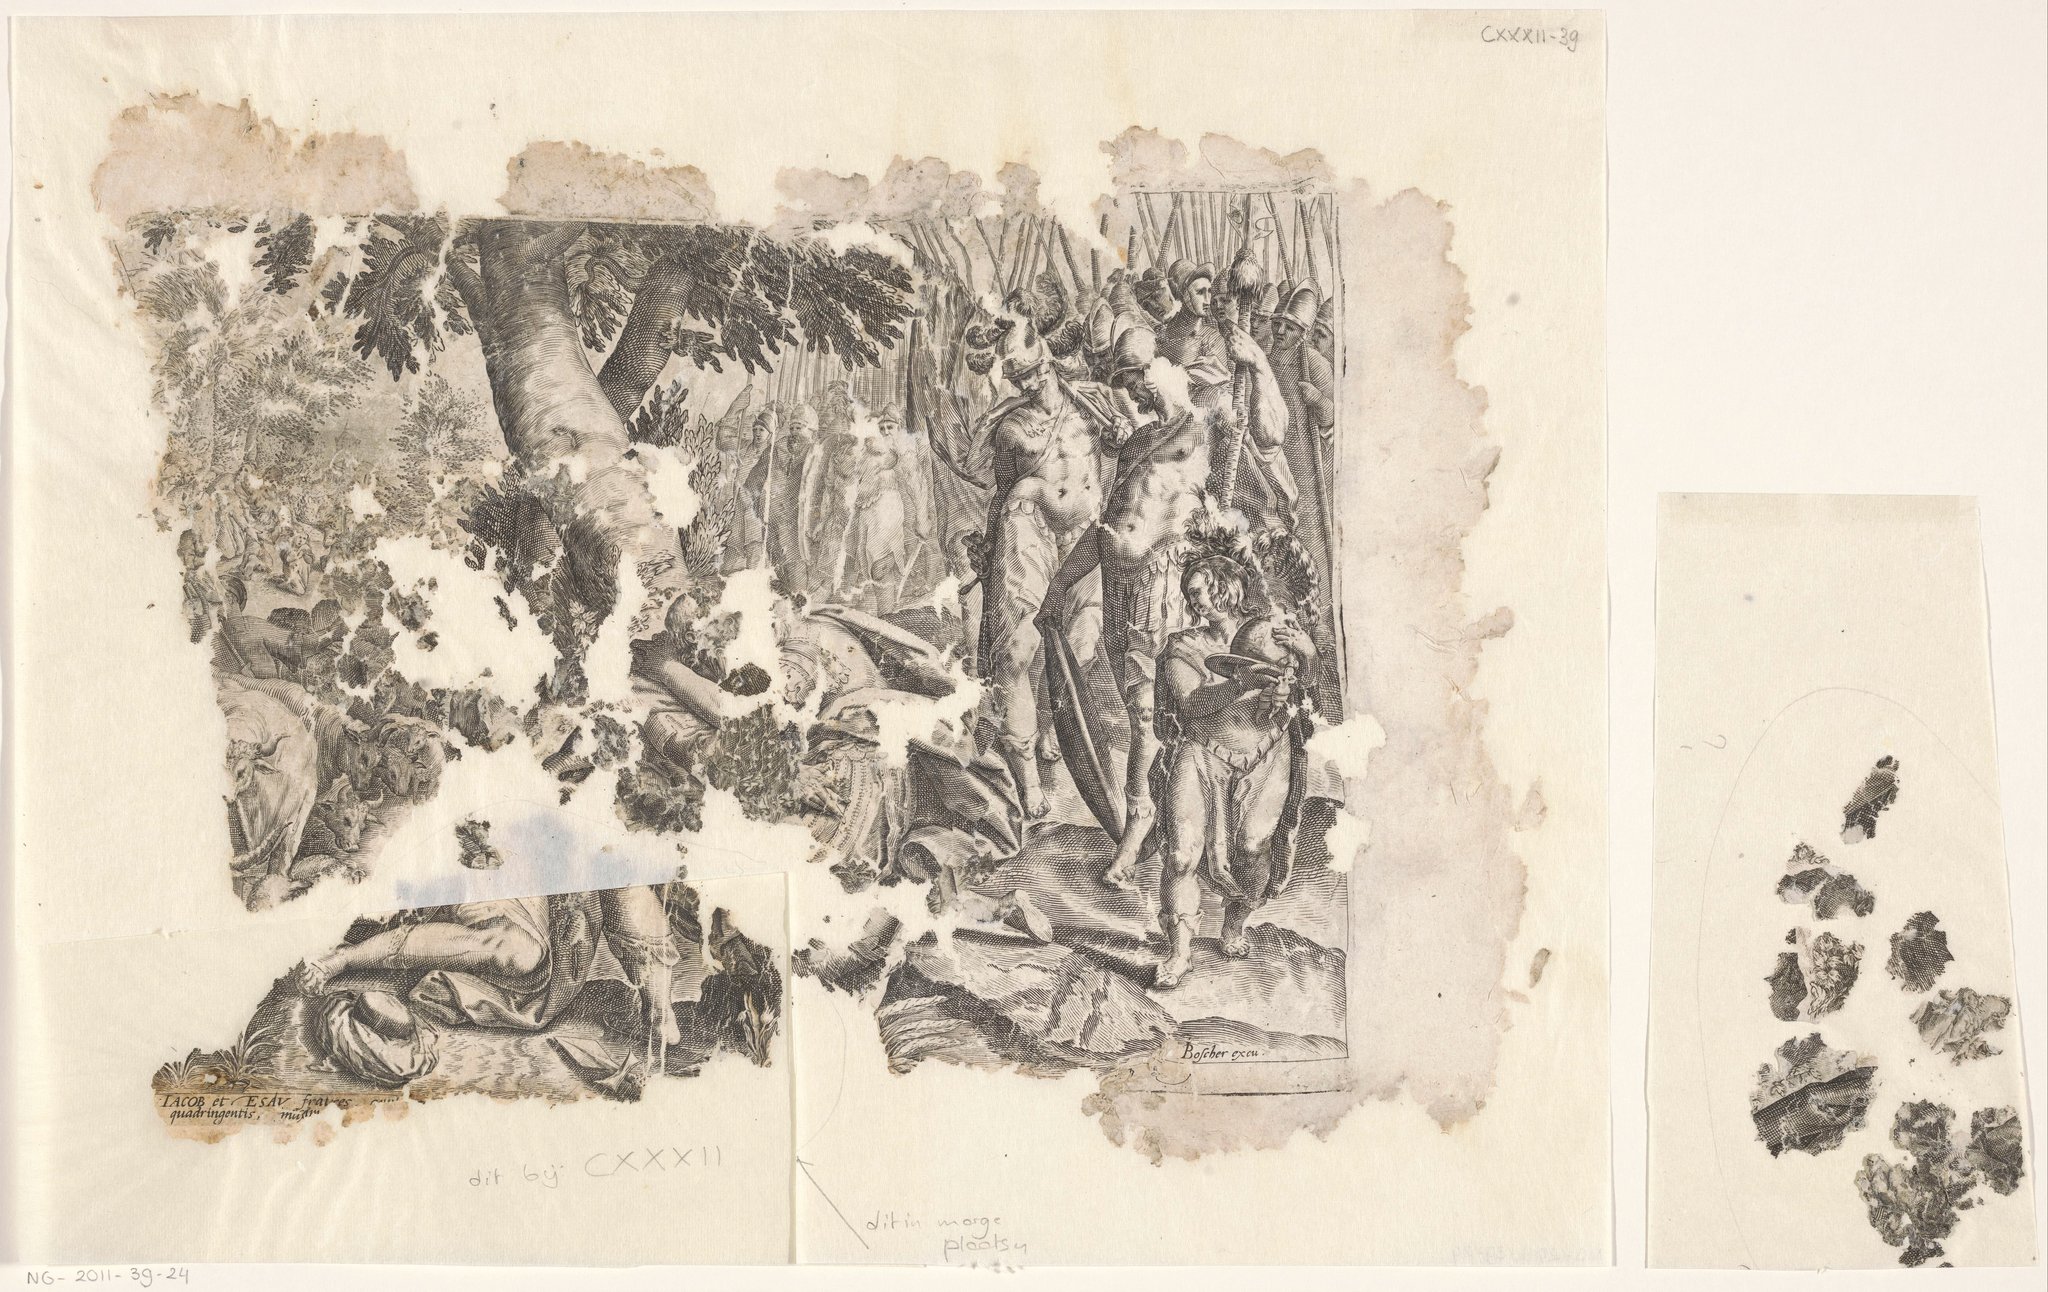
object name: print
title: Verzoening van Jakob en Esau en losse fragmenten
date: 1580-1596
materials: paper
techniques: engraving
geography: northern netherlands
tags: the meeting between esau and jacob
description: Tot dusverre was deze prent alleen bekend in een latere editie met het adres van C.J. Visscher in het door hem uitgegeven Theatrum Biblicum uit 1643, zie RP-P-1976-30-39. De prenten in de Nova Zembla collectie zijn tijdens een expeditie van Willem Barendsz en Jacob van Heemskerk in 1596-1597 noodgedwongen in het winterkamp, het ‘Behouden Huis’, op het eiland achtergelaten. De prenten waren in één of meerdere stapels als handelswaar meegenomen vanuit Amsterdam. Bijna drie eeuwen later, in 1871, keerde de Noor Elling Carlsen terug naar Nova Zembla en vond daar de restanten van het ‘Behouden Huis, inclusief een groot deel van de inventaris. Een deel van de prenten, in de vorm van aaneengekoekte kluiten, werd toen ook teruggevonden. De papierkluiten waren soms op meerdere plekken gebroken. Tussen 1975-1979 zijn de prenten van elkaar gescheiden. Dit leverde in totaal ca. 1000 fragmenten van ca. 400 afdrukken van ca. 150 verschillende prenten op. Voor zover mogelijk zijn de fragmenten samengevoegd en zijn de prenten gereconstrueerd.